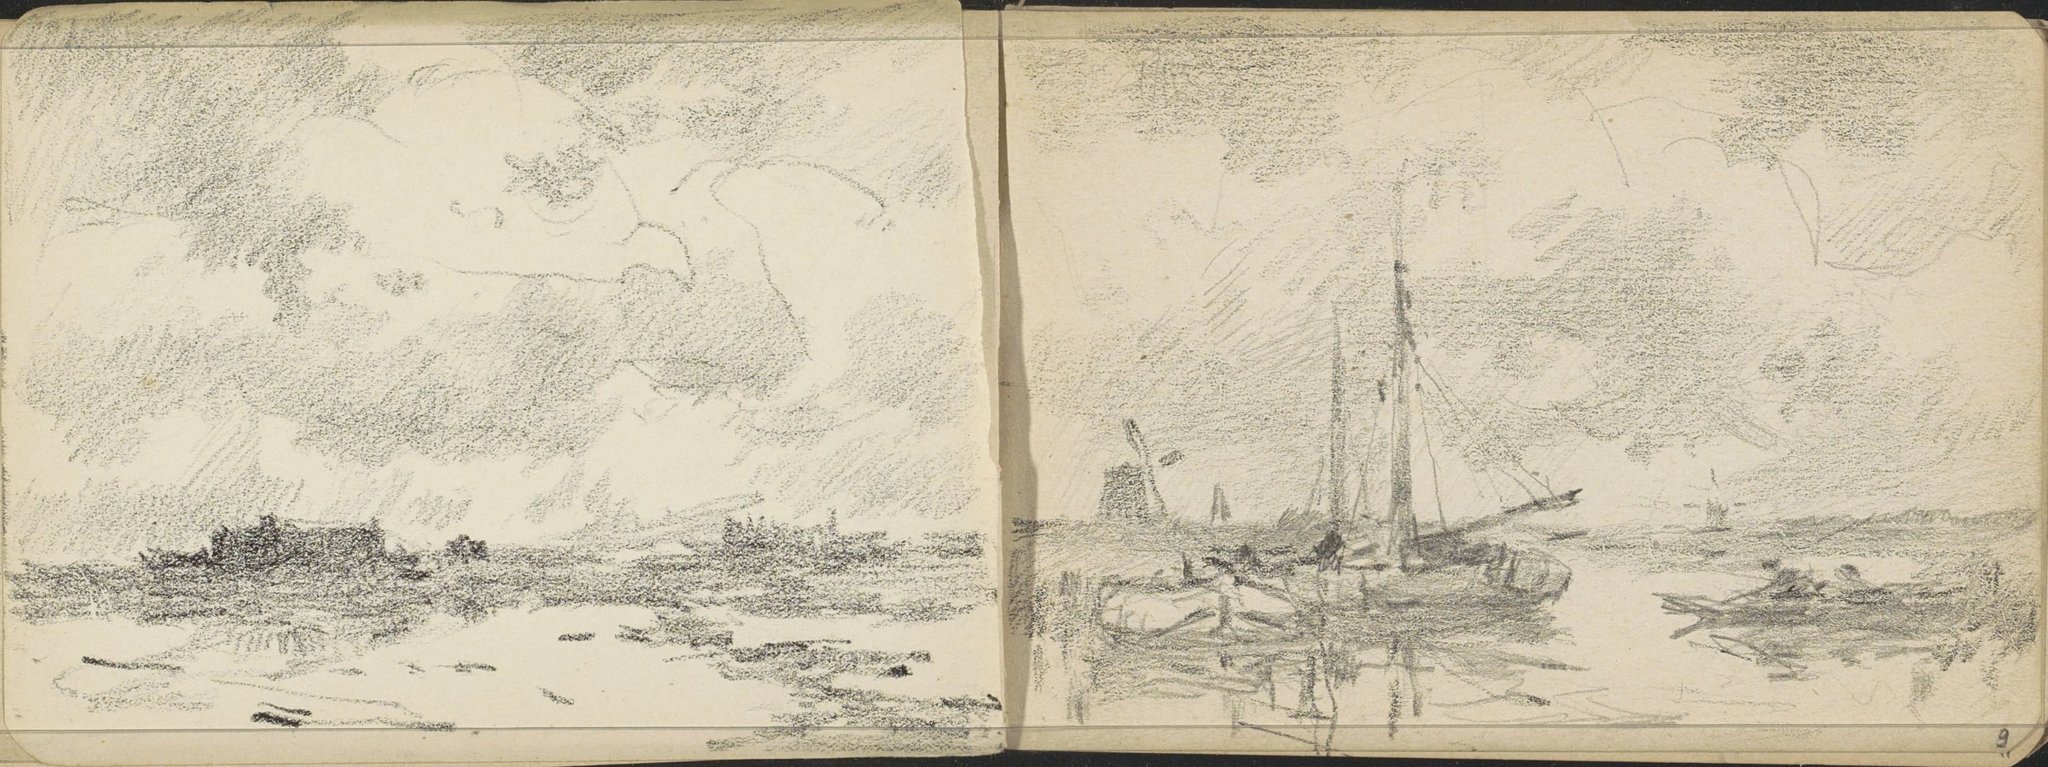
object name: sketchbook leaf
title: Zeil- en roeiboten op het water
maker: willem cornelis rip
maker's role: draughtsman, painter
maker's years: 1856-1922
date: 1919-1921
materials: chalk, paper, pencil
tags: sailing-ship, sailing-boat, landscapes with waters, waterscapes, seascapes (in the temperate zone), windmill in landscape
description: Op de achtergrond een landschap met molens. Blad 8 verso en 9 recto uit een schetsboek met 42 bladen.